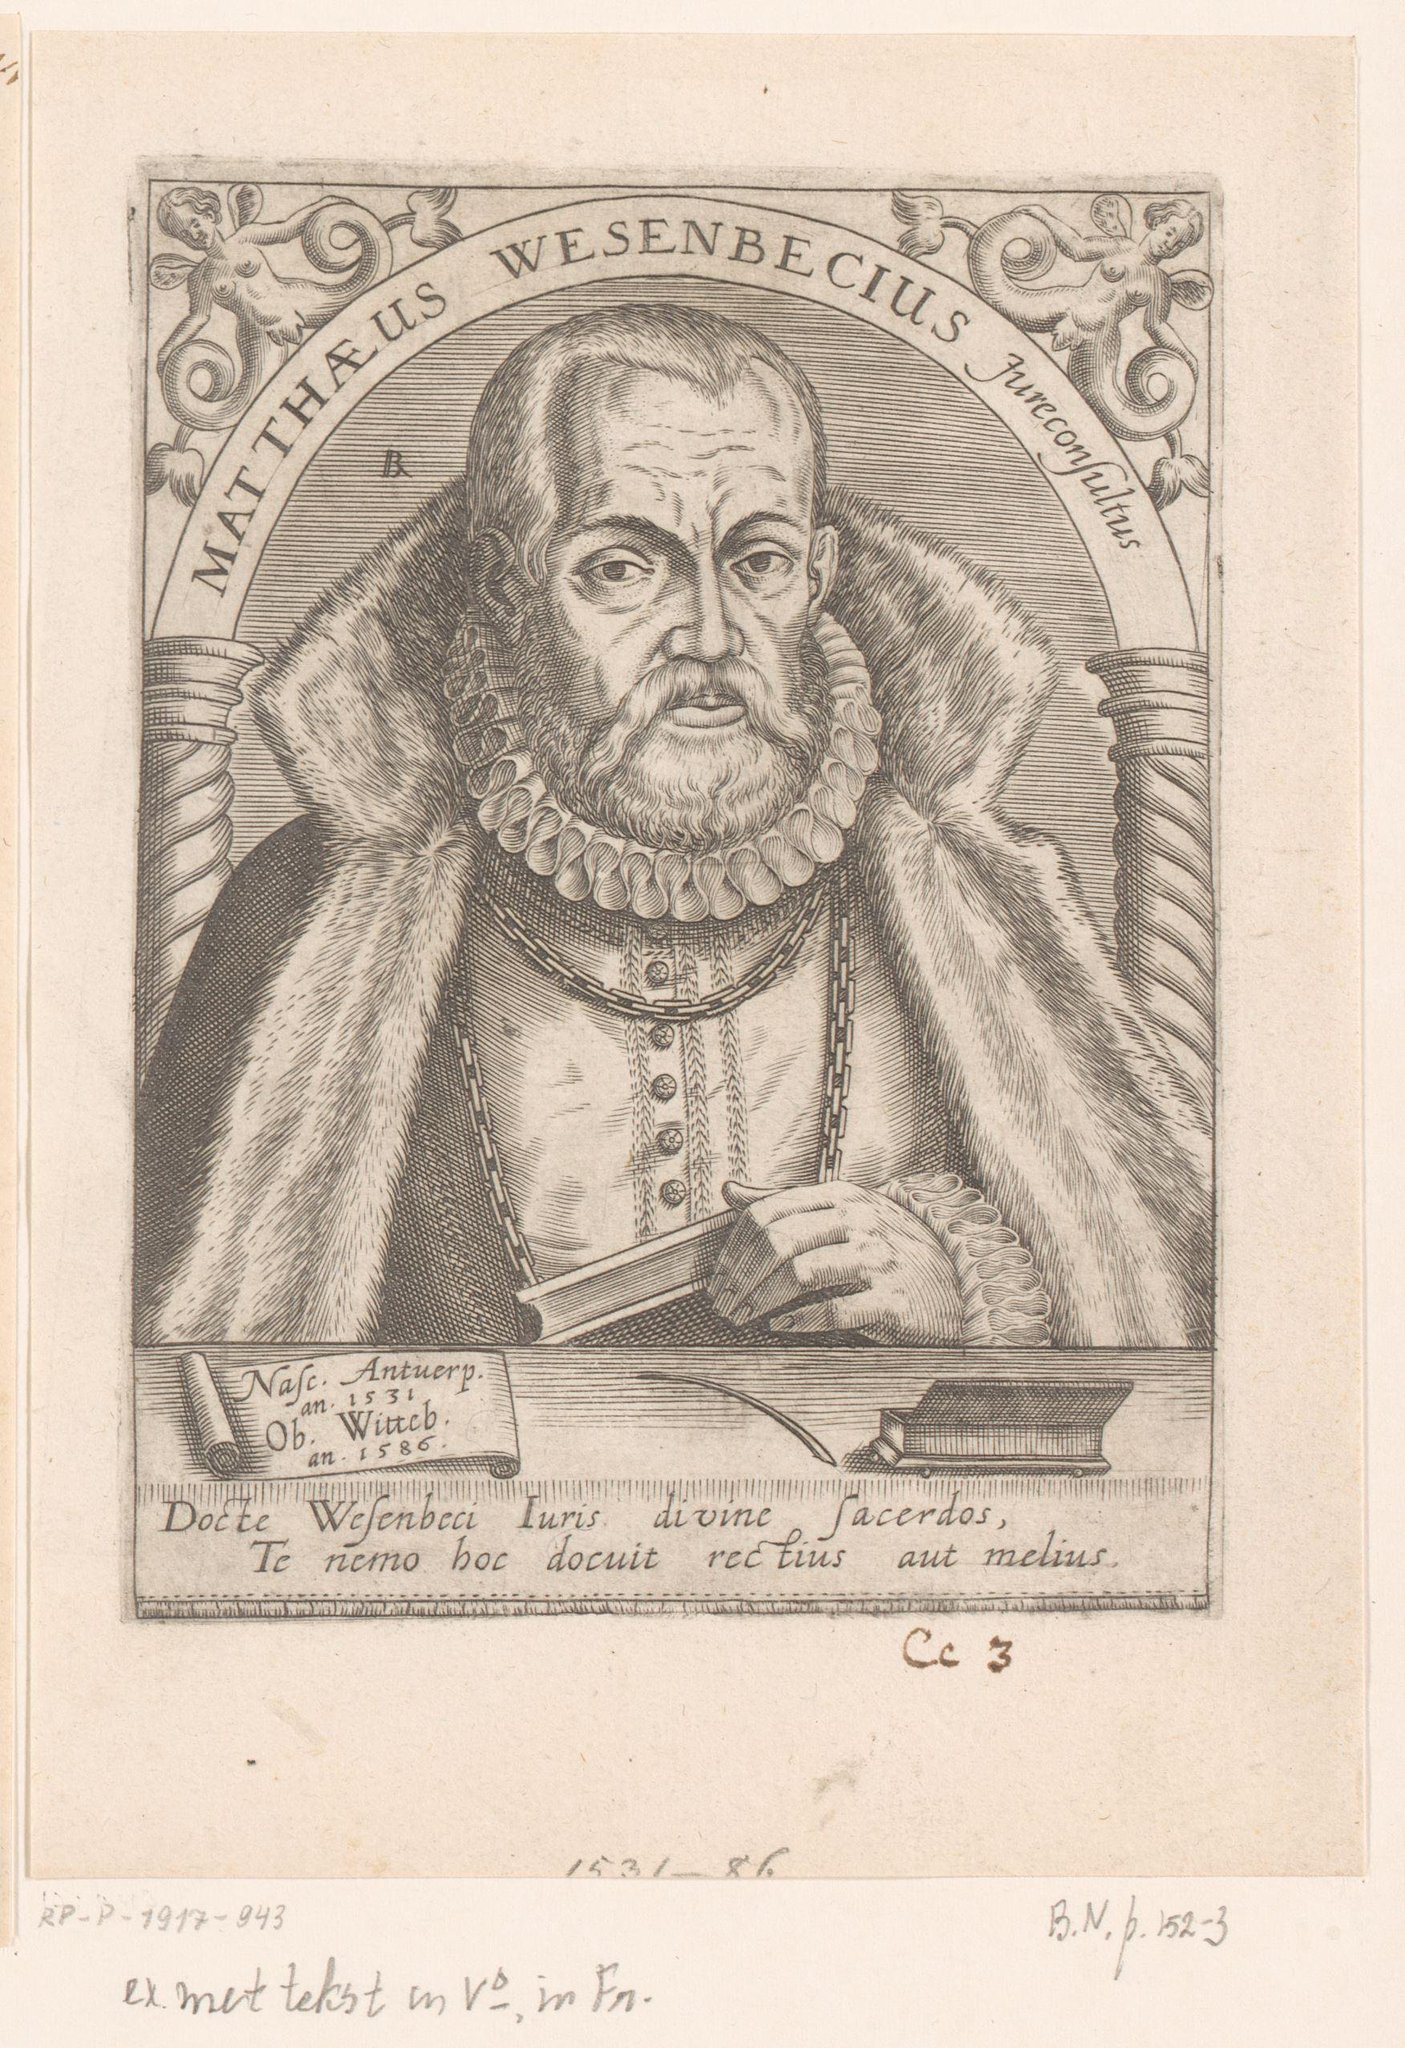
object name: print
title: Portret van Matthew Wesenbeck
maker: robert boissard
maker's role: print maker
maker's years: 1570-1611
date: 1597-1599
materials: paper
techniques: engraving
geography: france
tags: historical persons, book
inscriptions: collector's mark: Lugt 2228, inscription: ‘Cc 3’